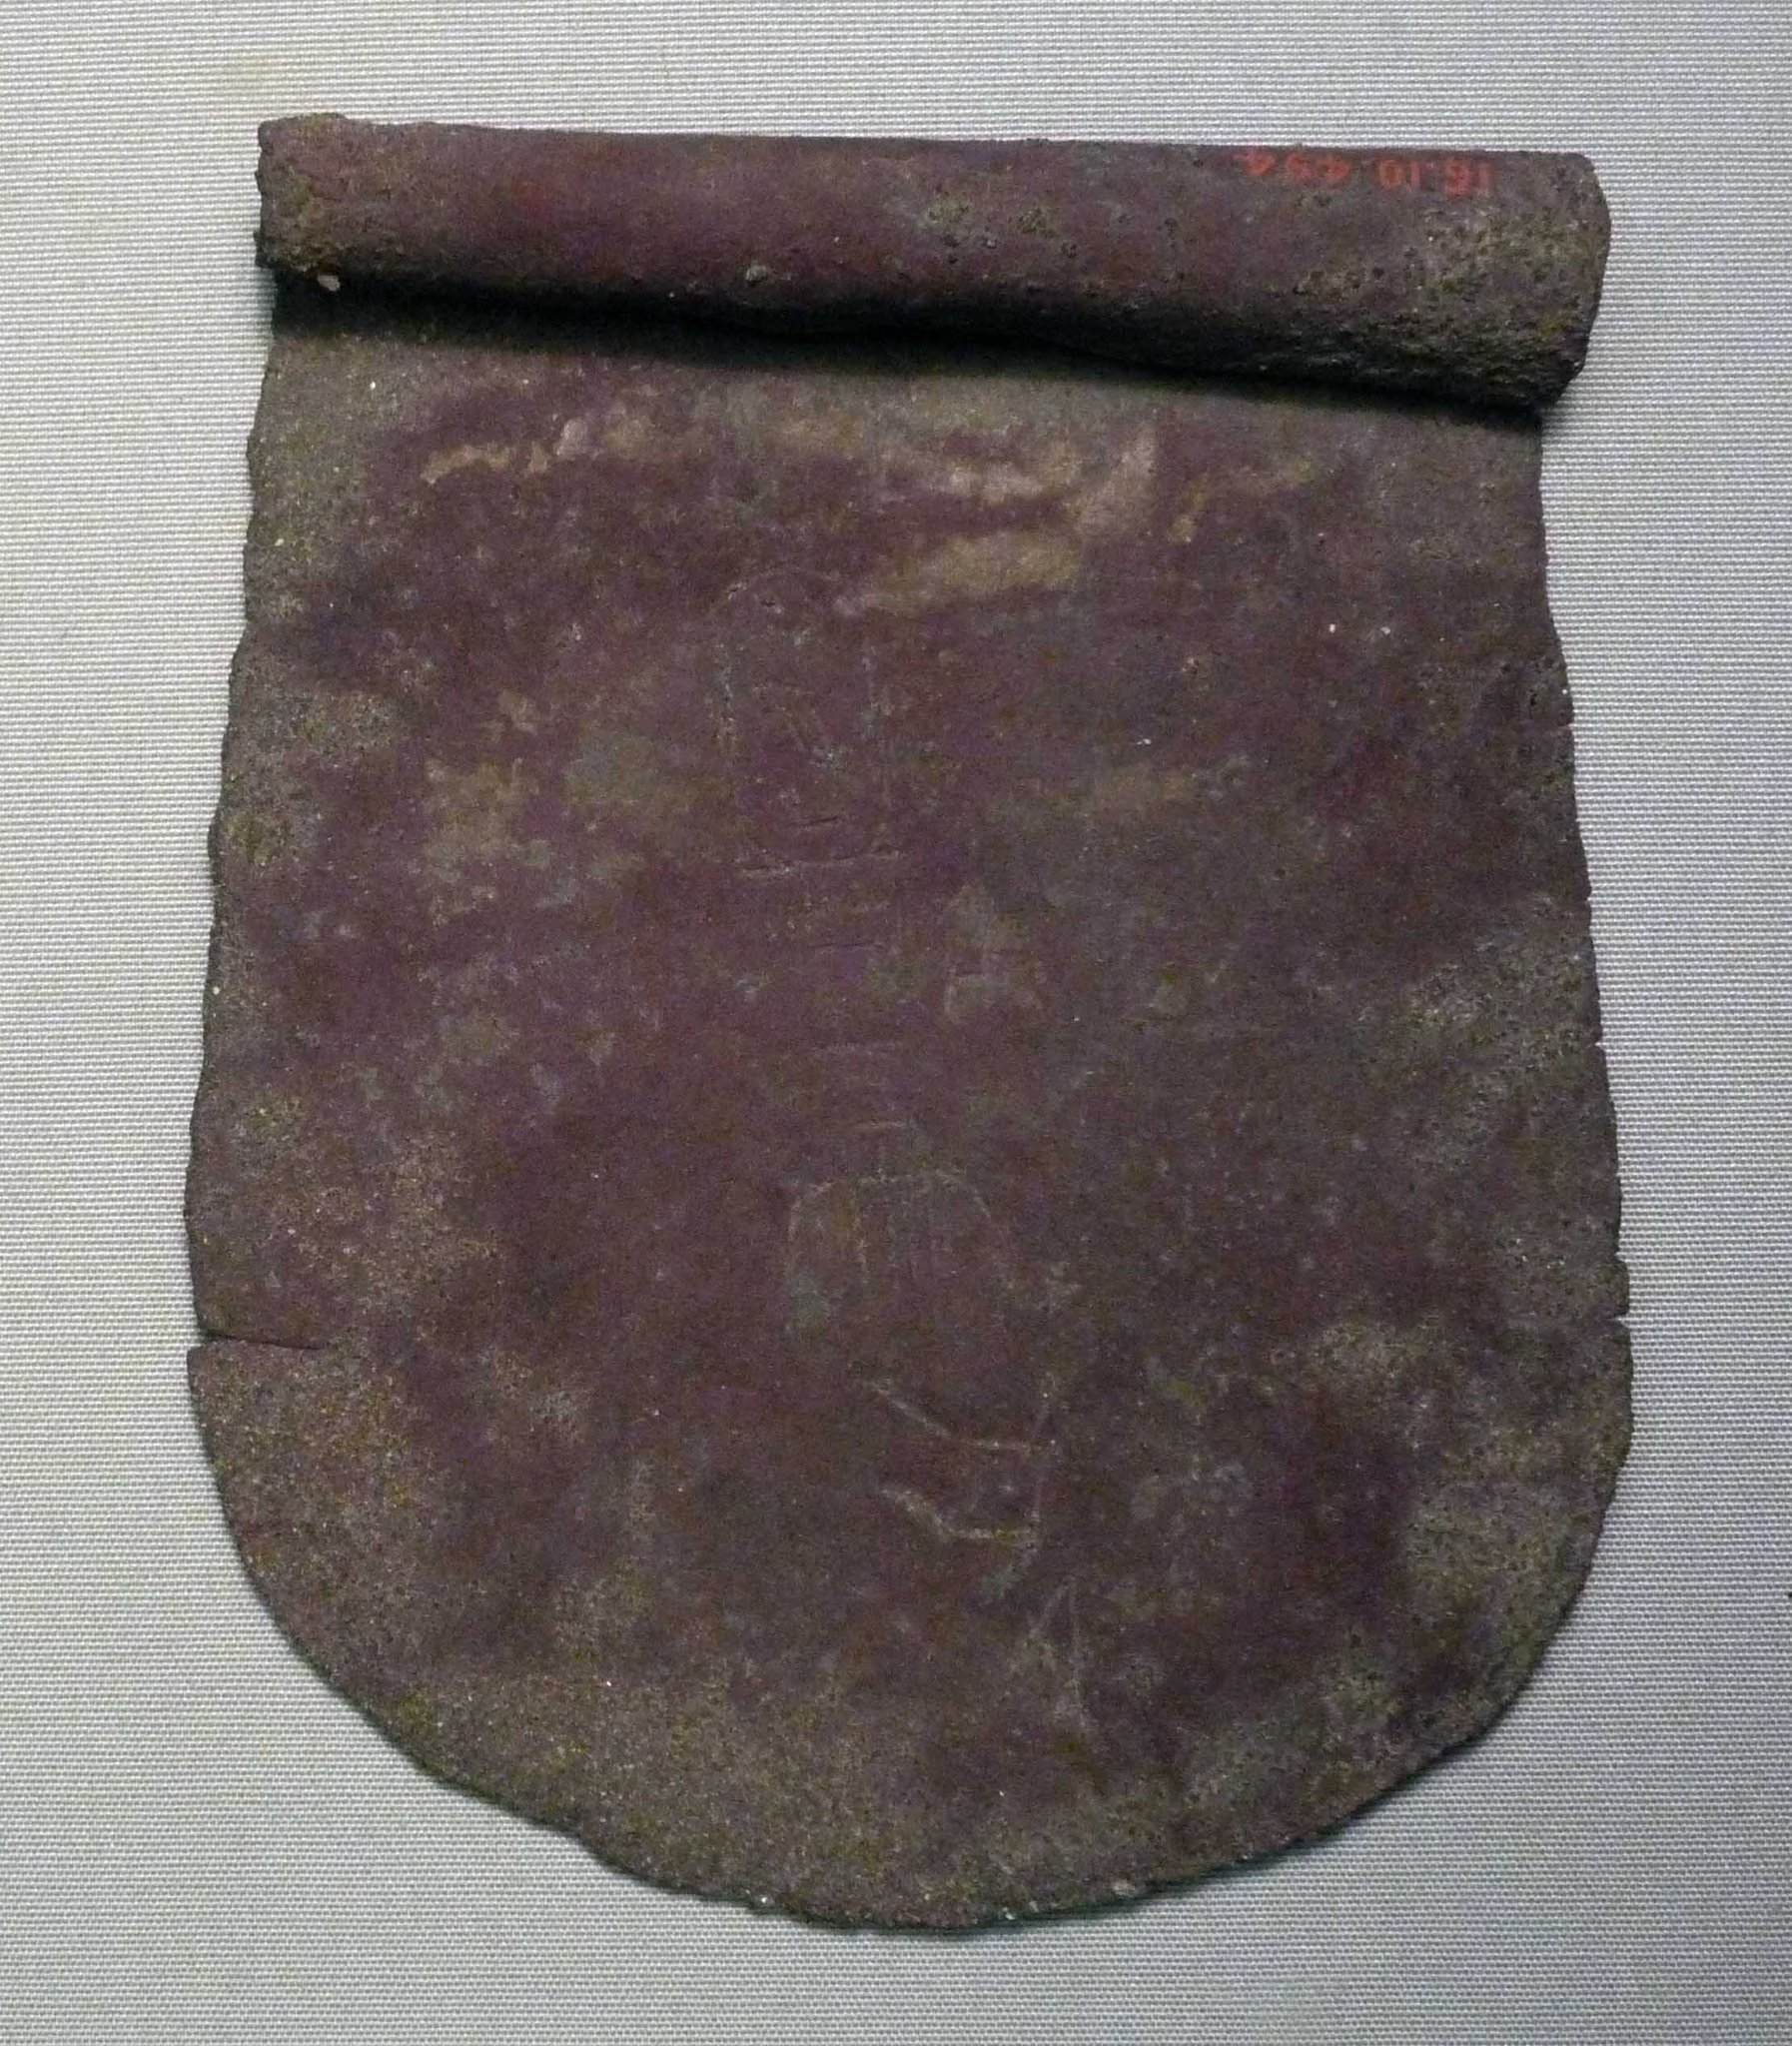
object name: ax blade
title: Inscribed Ax Blade From Foundation Deposit 2 of Hatshepsut's Valley Temple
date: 1479-1458 BCE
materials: bronze, copper alloy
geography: egypt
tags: cartouches,hieroglyphs